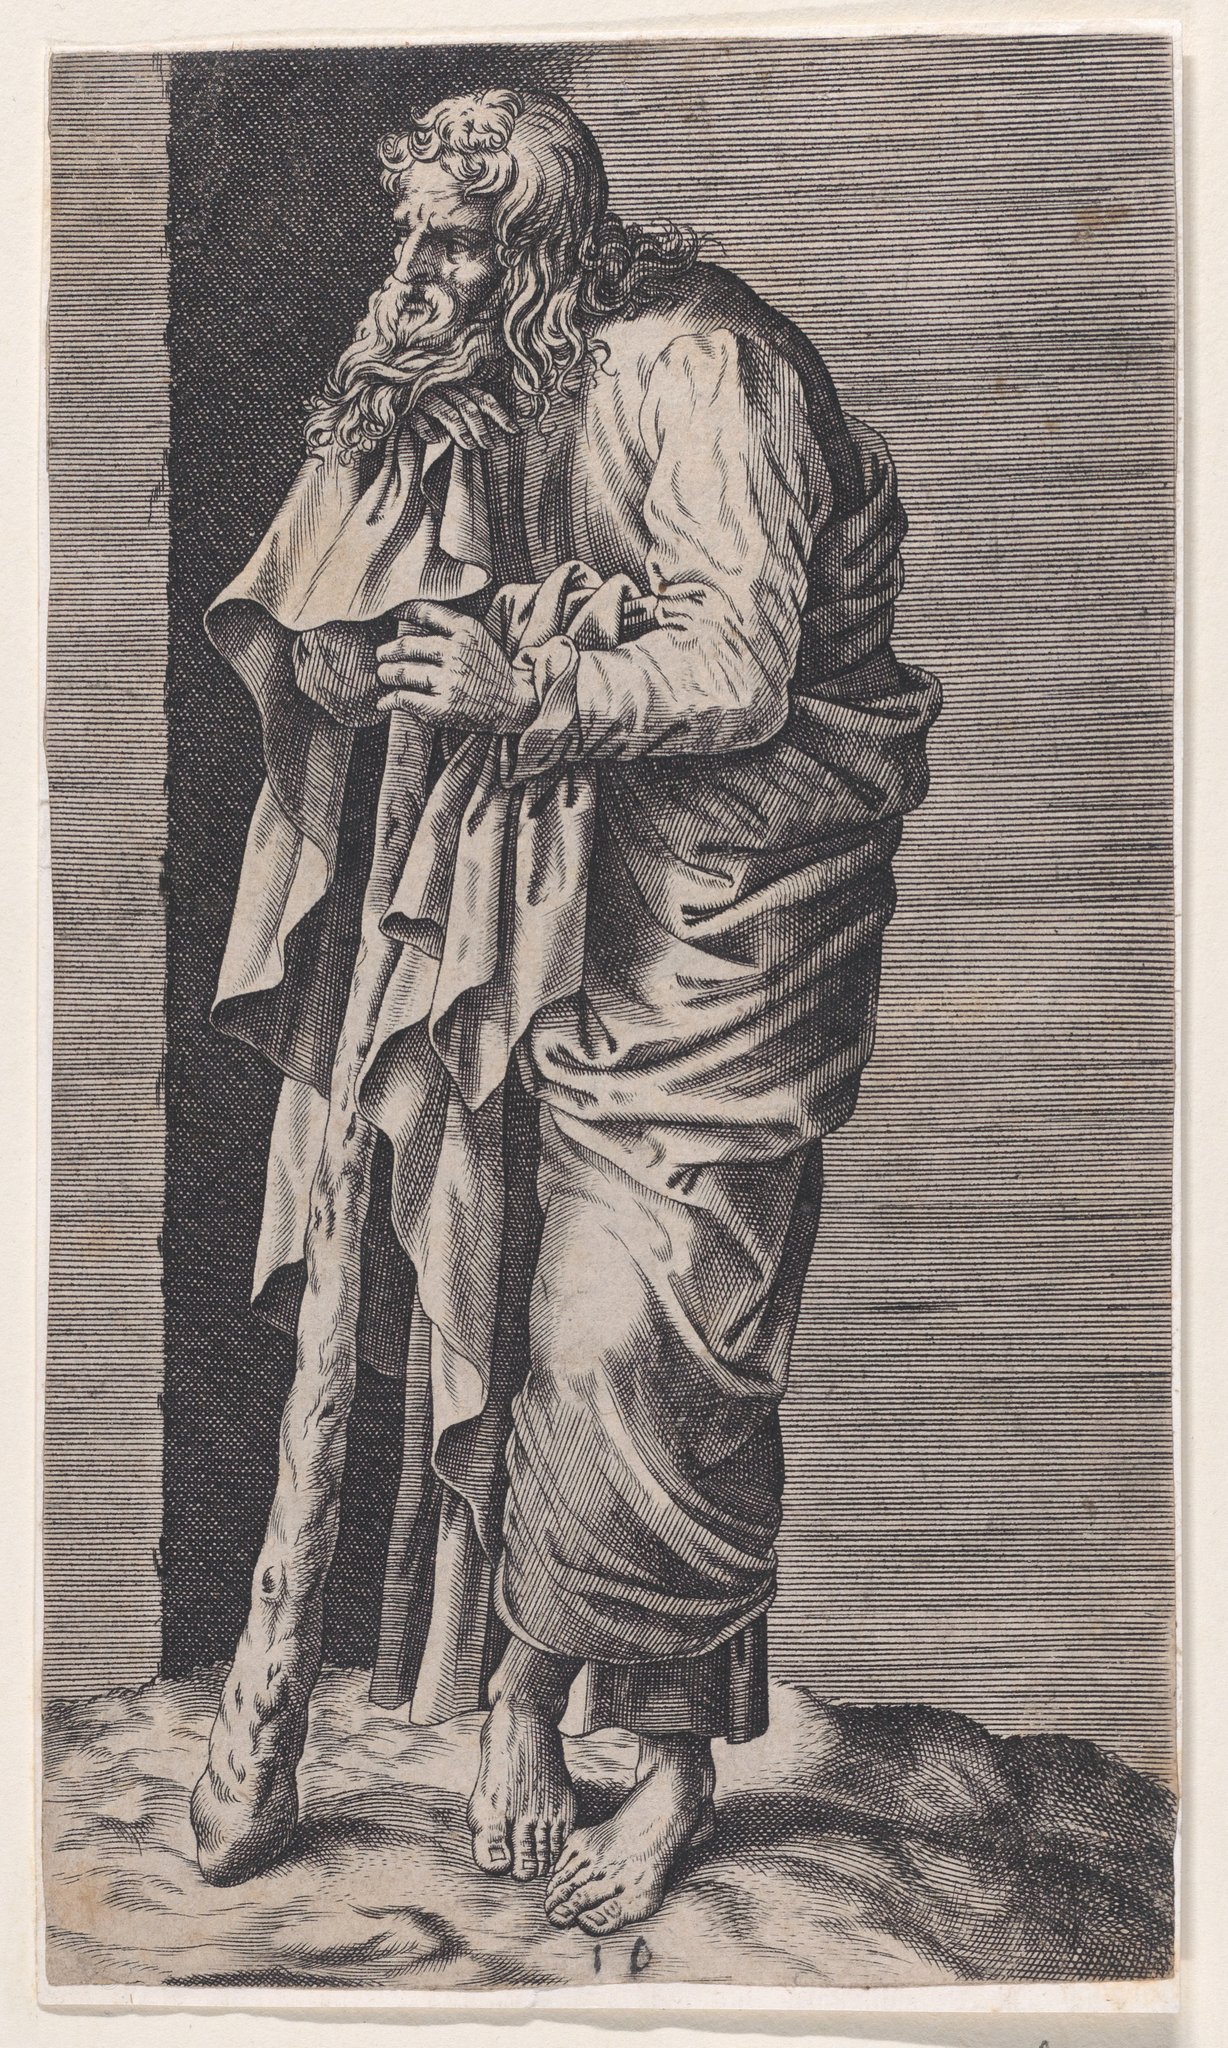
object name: print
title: St. Jacob Minor, from "Christ and the Apostles"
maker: lambert suavius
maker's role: artist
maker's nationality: netherlandish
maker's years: 1510-1576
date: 1530-1576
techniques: backing, engraving